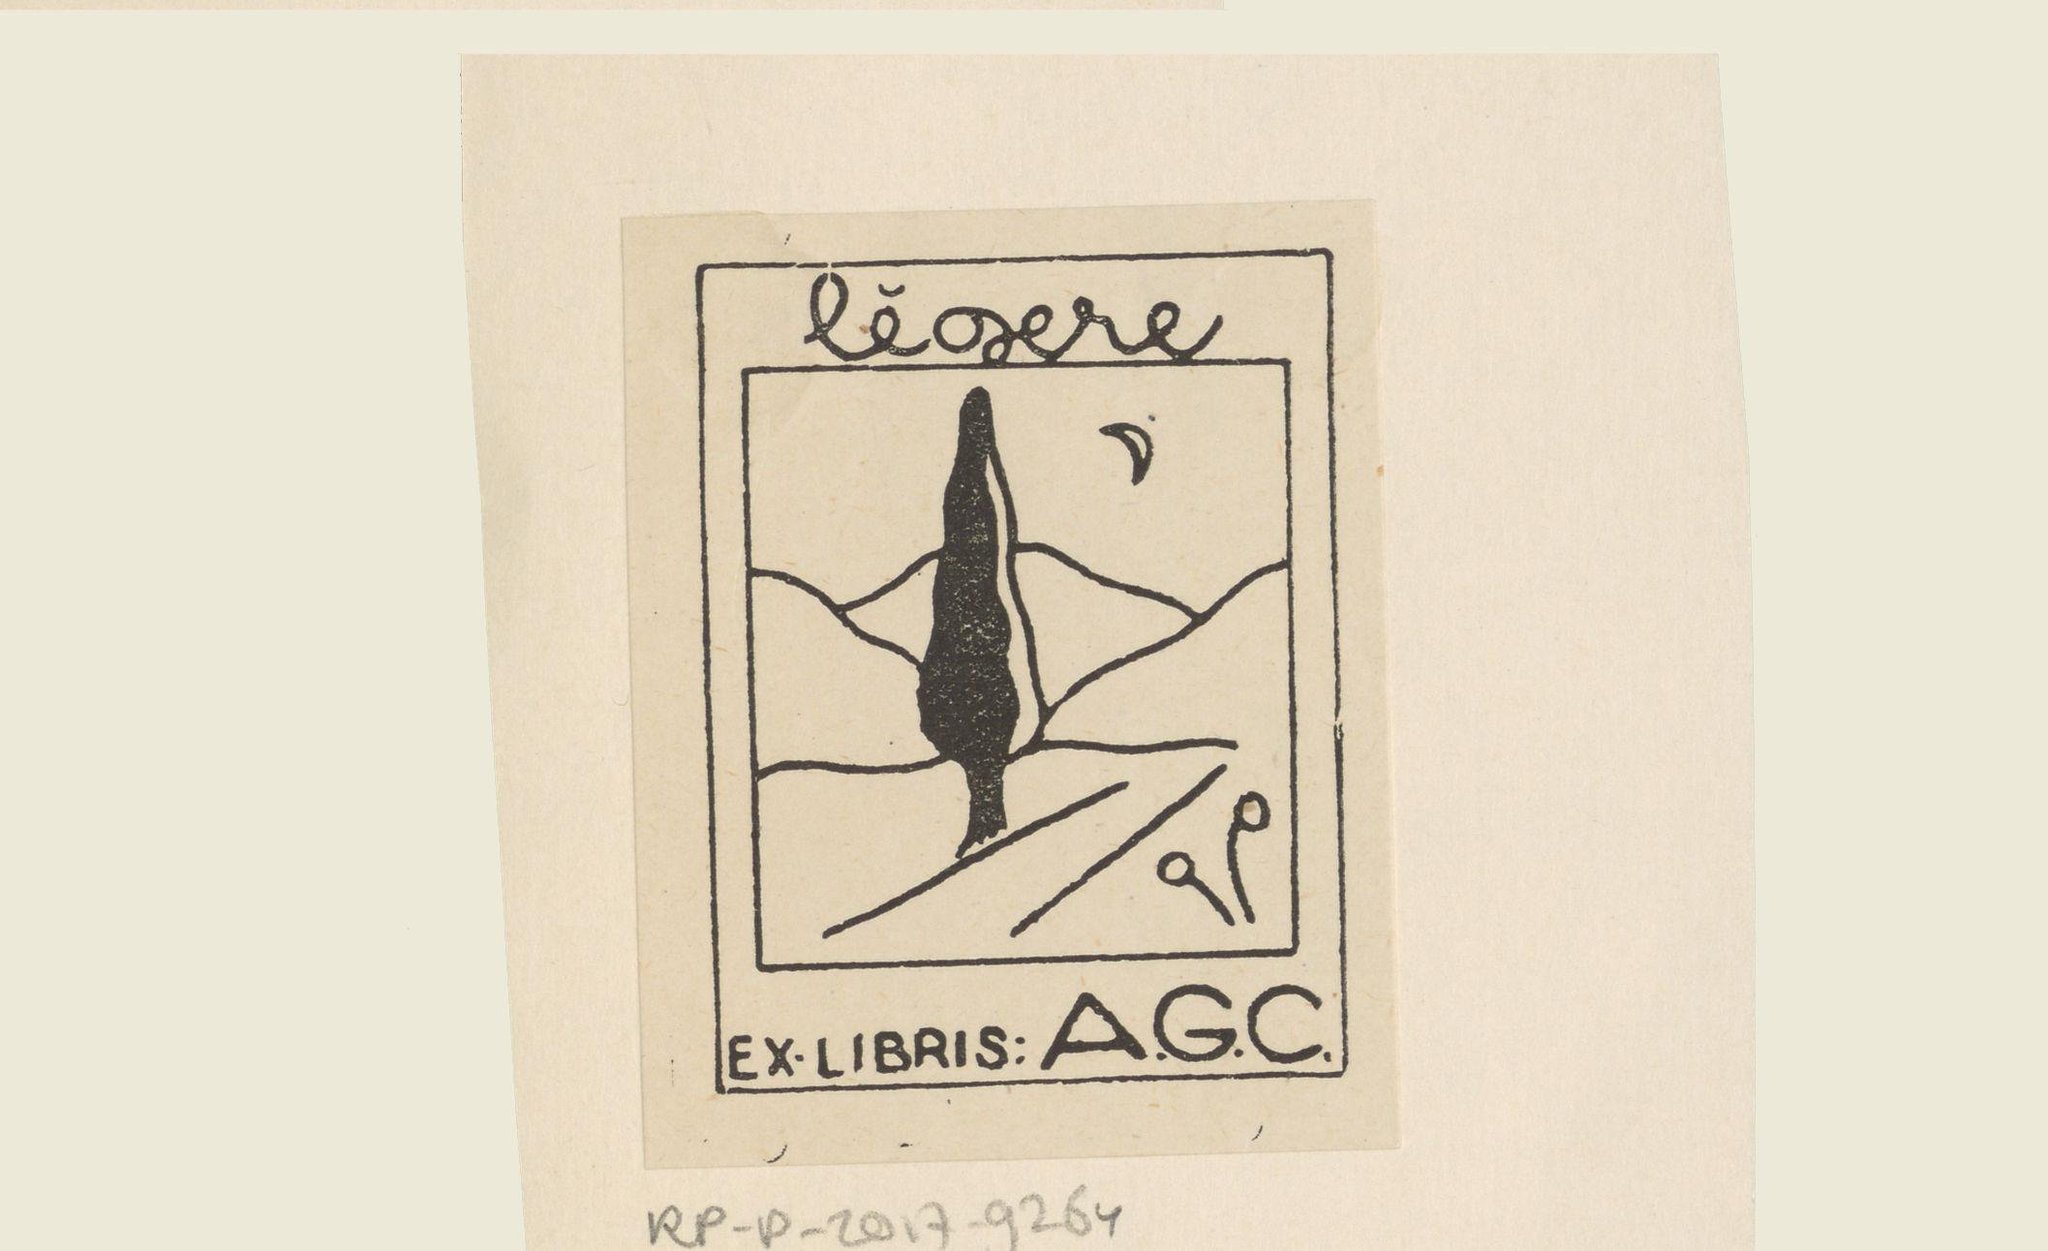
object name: bookplate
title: Ex libris van A.G.C.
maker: Anonymous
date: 1900-1999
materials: paper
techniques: printing block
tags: trees, landscapes